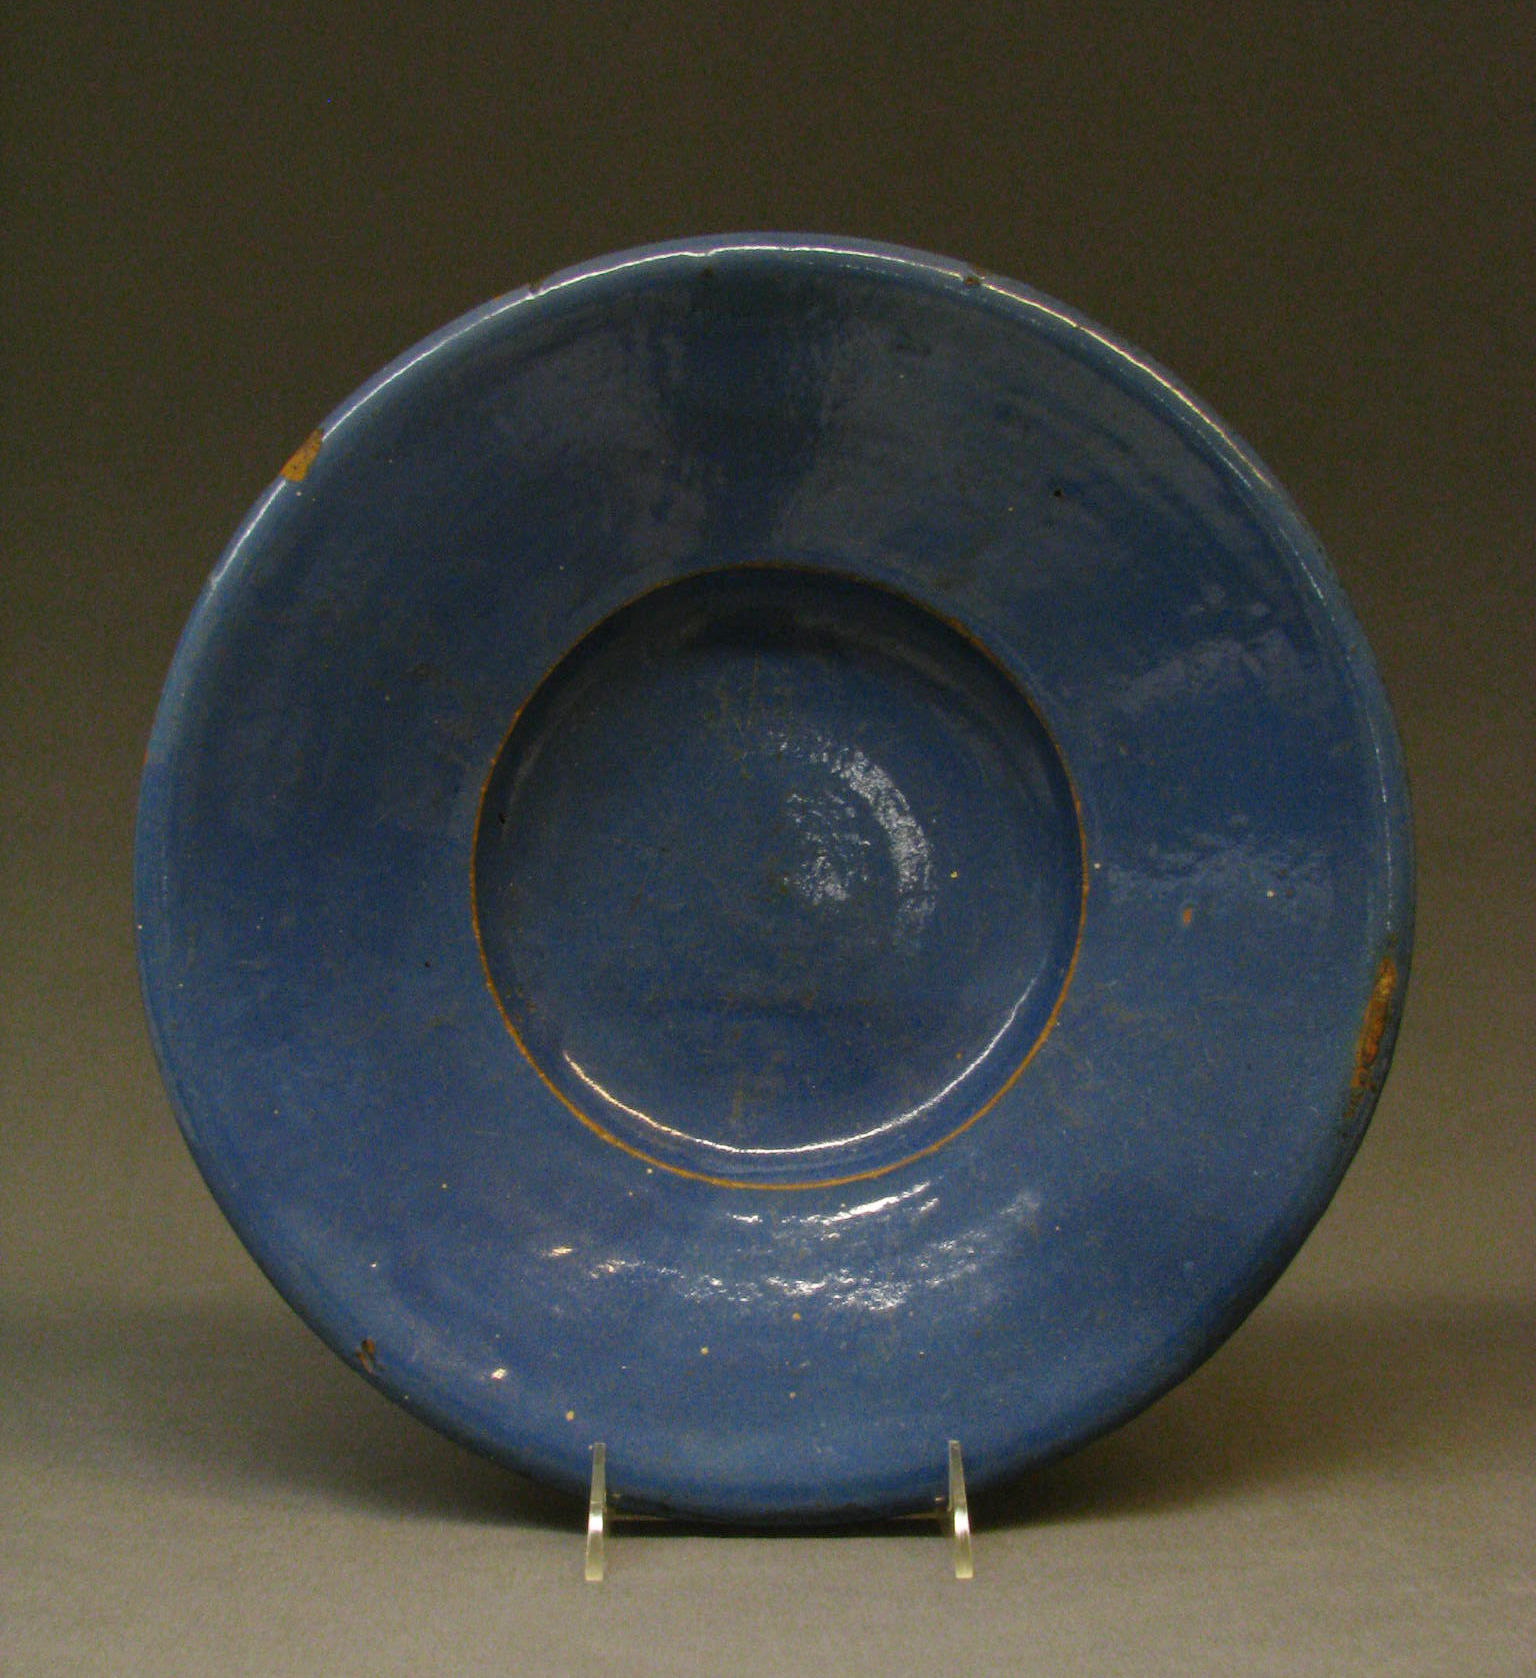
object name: dish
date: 1701-1800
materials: pottery